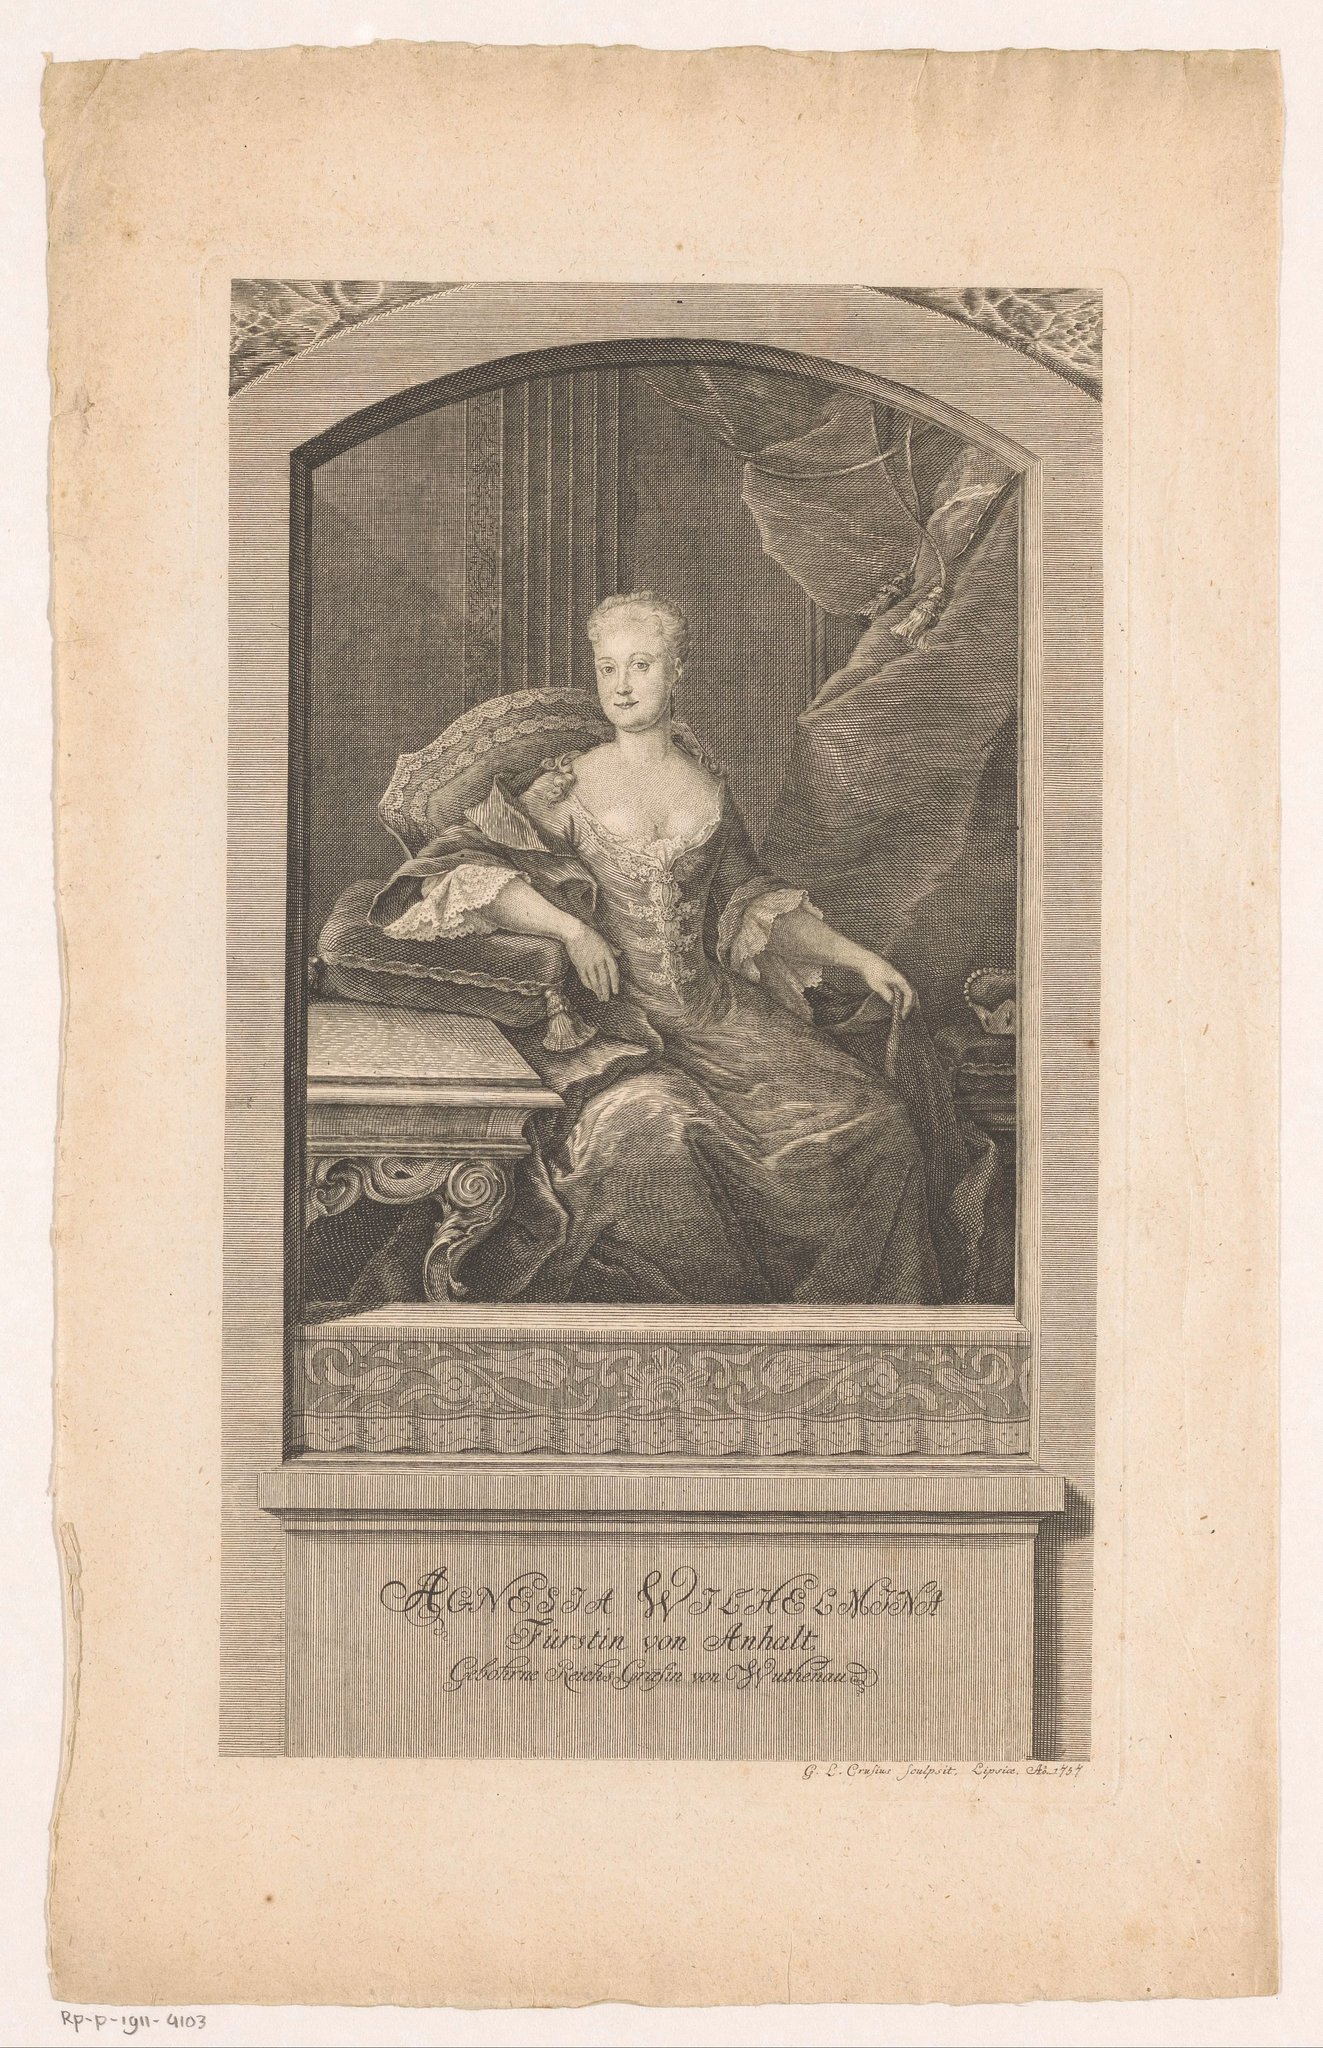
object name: print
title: Portret van Agnes Wilhelmine Füstin von Anhalt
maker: gottlieb leberecht crusius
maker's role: print maker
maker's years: 1730-1804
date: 1757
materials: paper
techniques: engraving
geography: leipzig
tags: agnes wilhelmine von warmsdorf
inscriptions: collector's mark: Lugt 2228